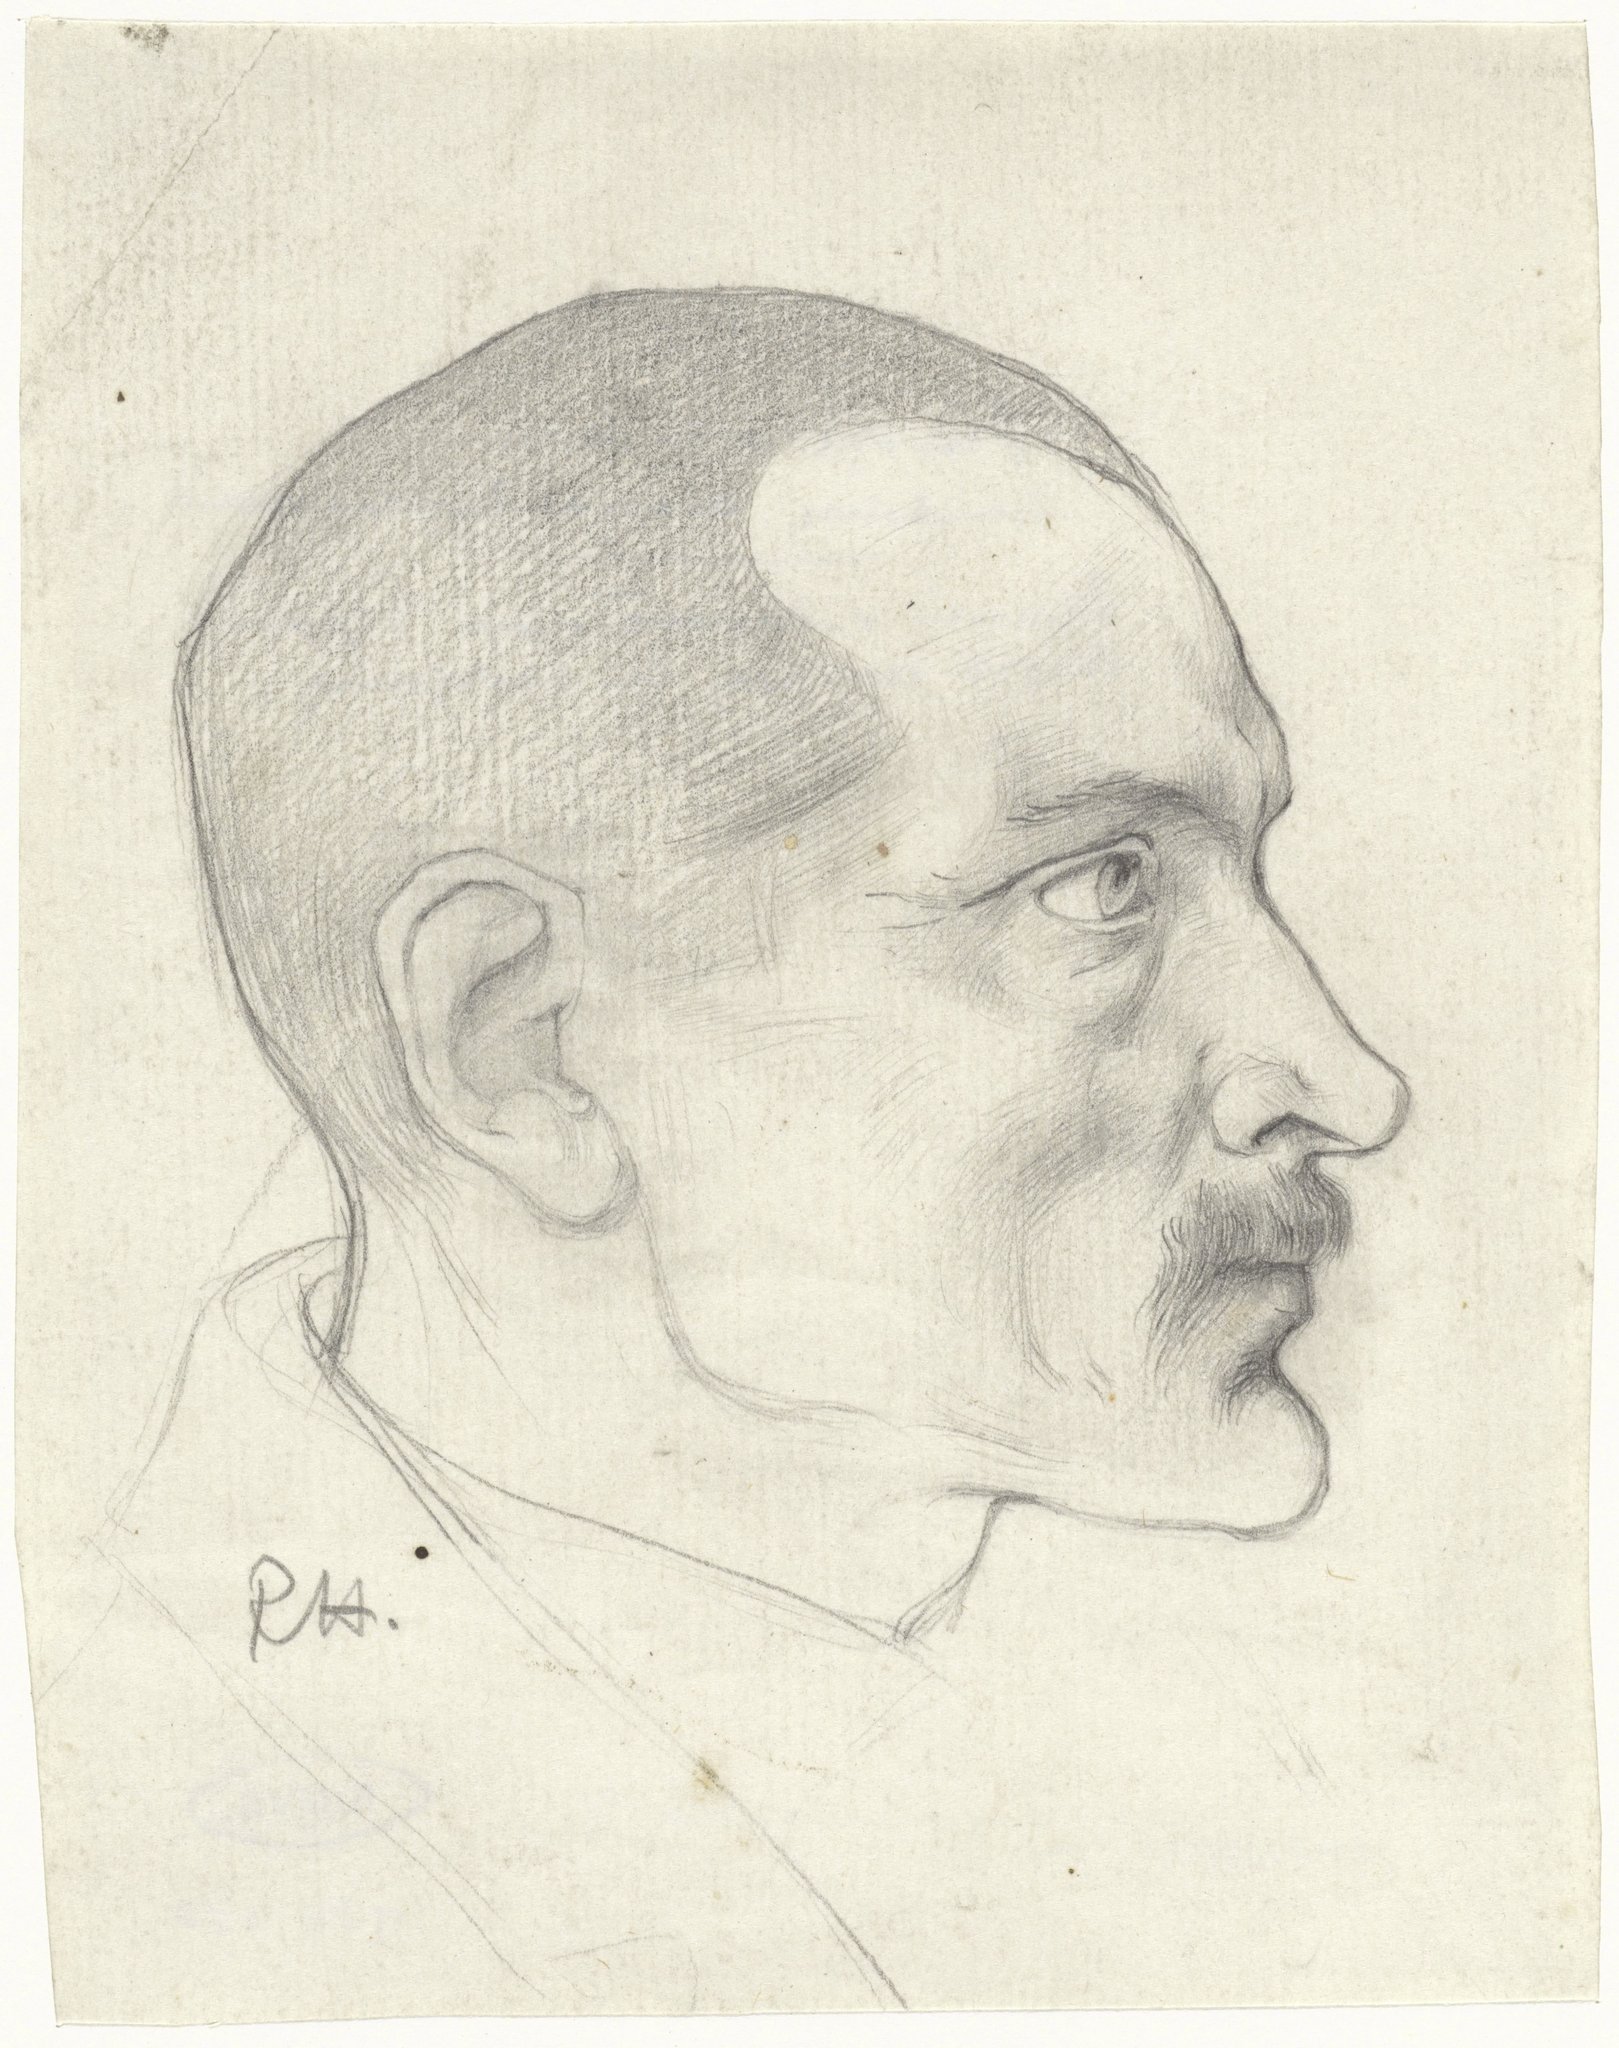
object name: drawing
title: Kop van een man met snor, van opzij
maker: richard nicolaüs roland holst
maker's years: 1868-1938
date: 1878-1938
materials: paper, pencil